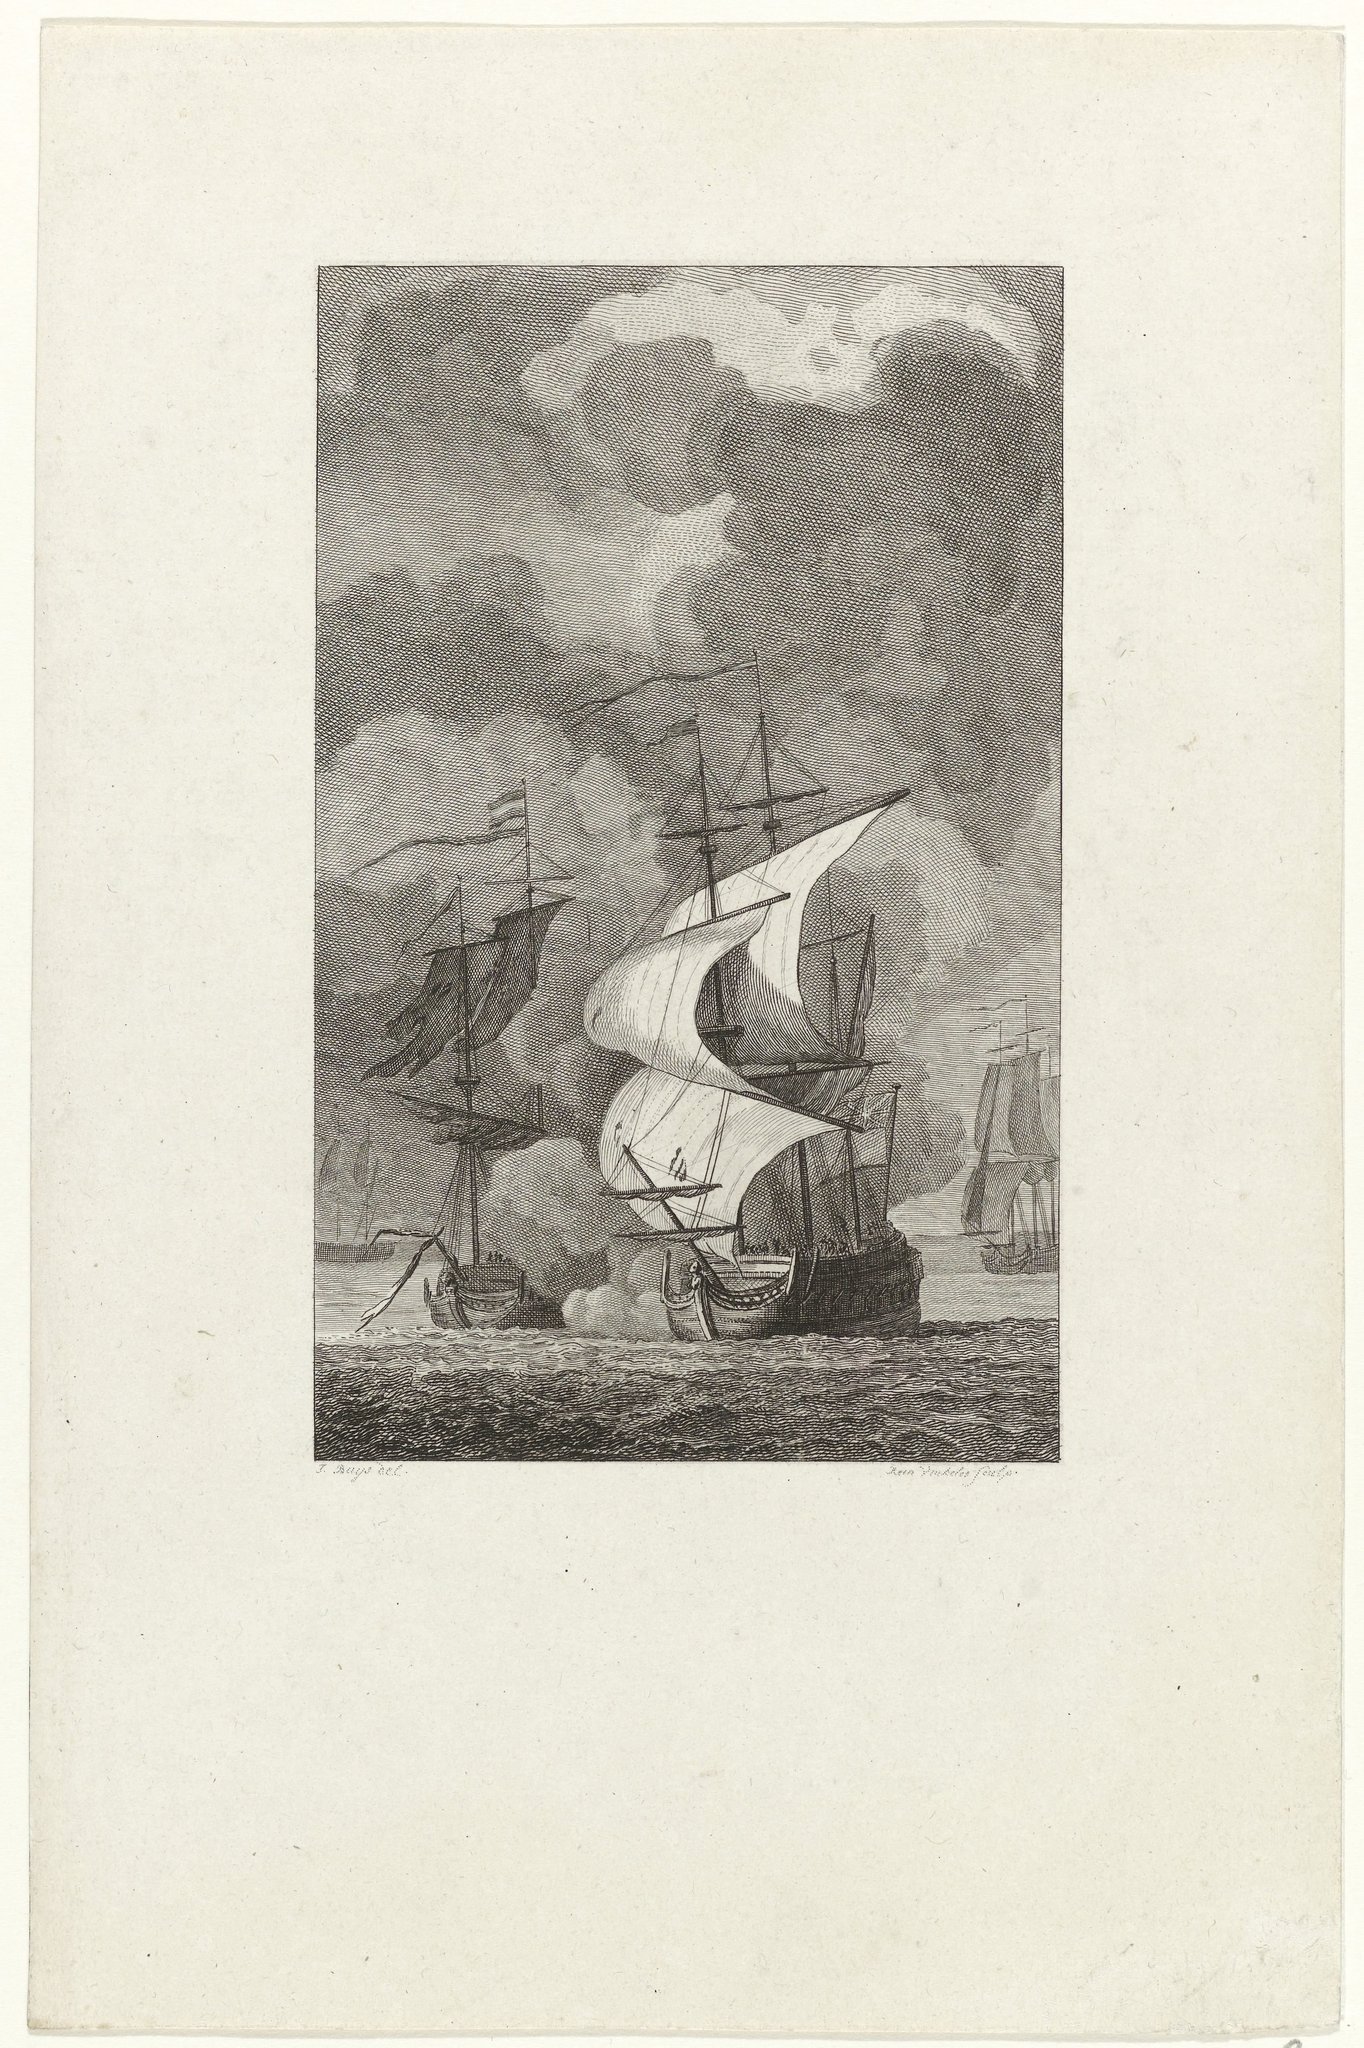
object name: print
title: Jarry sneuvelt in een gevecht met de Engelsen, 1783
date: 1791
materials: paper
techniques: engraving, etching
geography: northern netherlands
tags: capuche, battle (+ naval force), fourth anglo-dutch war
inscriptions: collector's mark: Lugt 2228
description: Gebruikt als illustratie: P.A. Loosjes. Vaderlandsche historie, vervattende de geschiedenissen, der Vereenigde Nederlanden (...). Ten onmiddelyken vervolge van Wagenaar's Vaderlandsche historie, dl. 6. Amsterdam: Johannes. Allart, dl. VI, 1791.